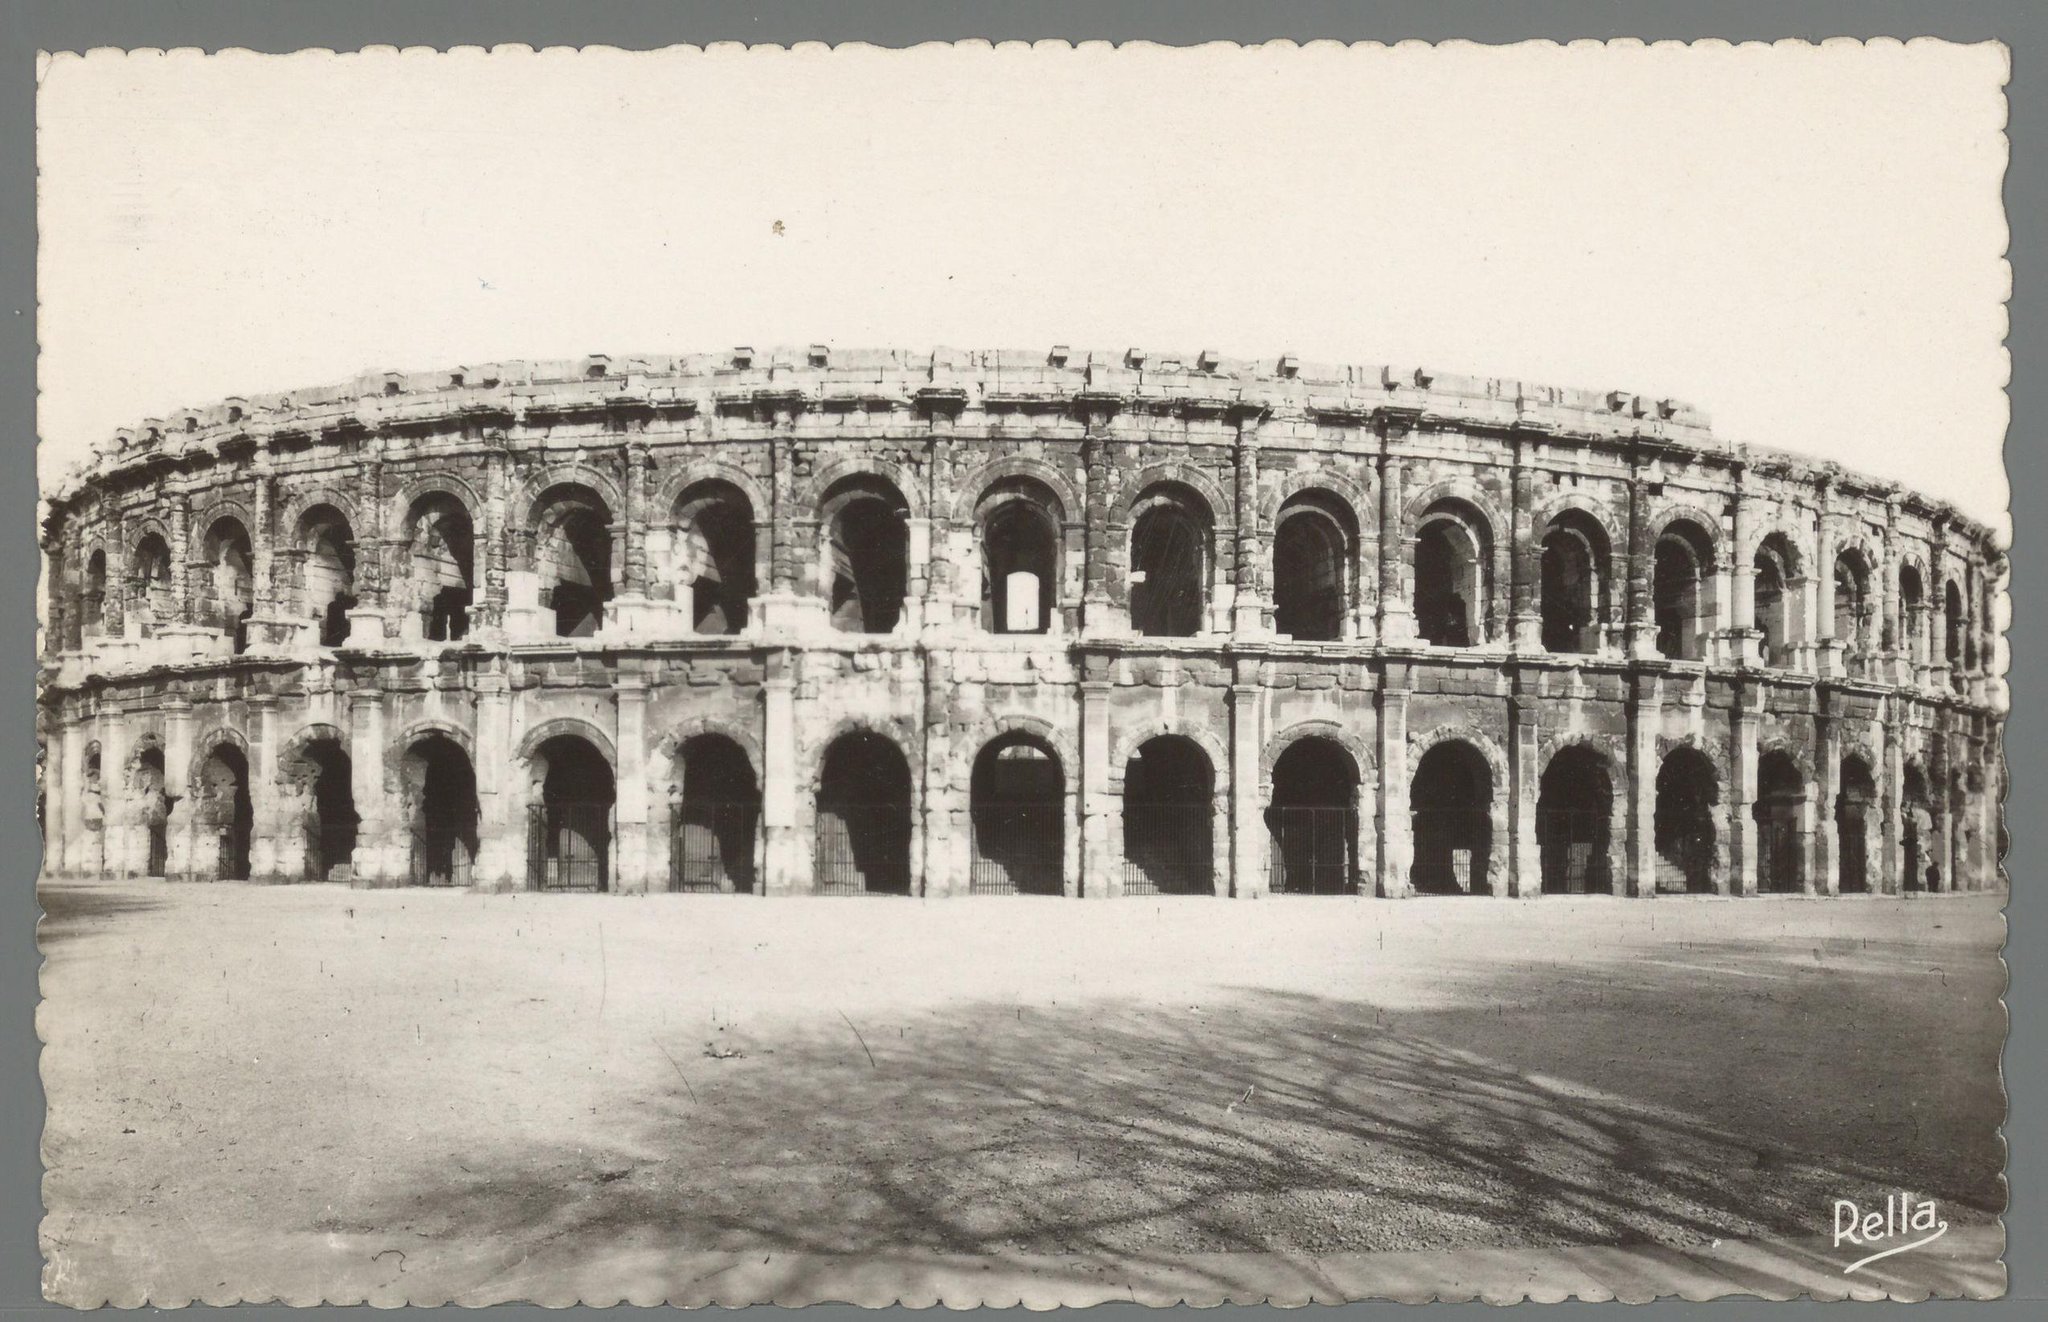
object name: ansichtkaart, prentbriefkaart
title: Nîmes (Gard). Les Arènes Romaines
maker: Anonymous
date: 1930-1950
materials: photographic support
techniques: photography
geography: nîmes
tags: amphitheatre